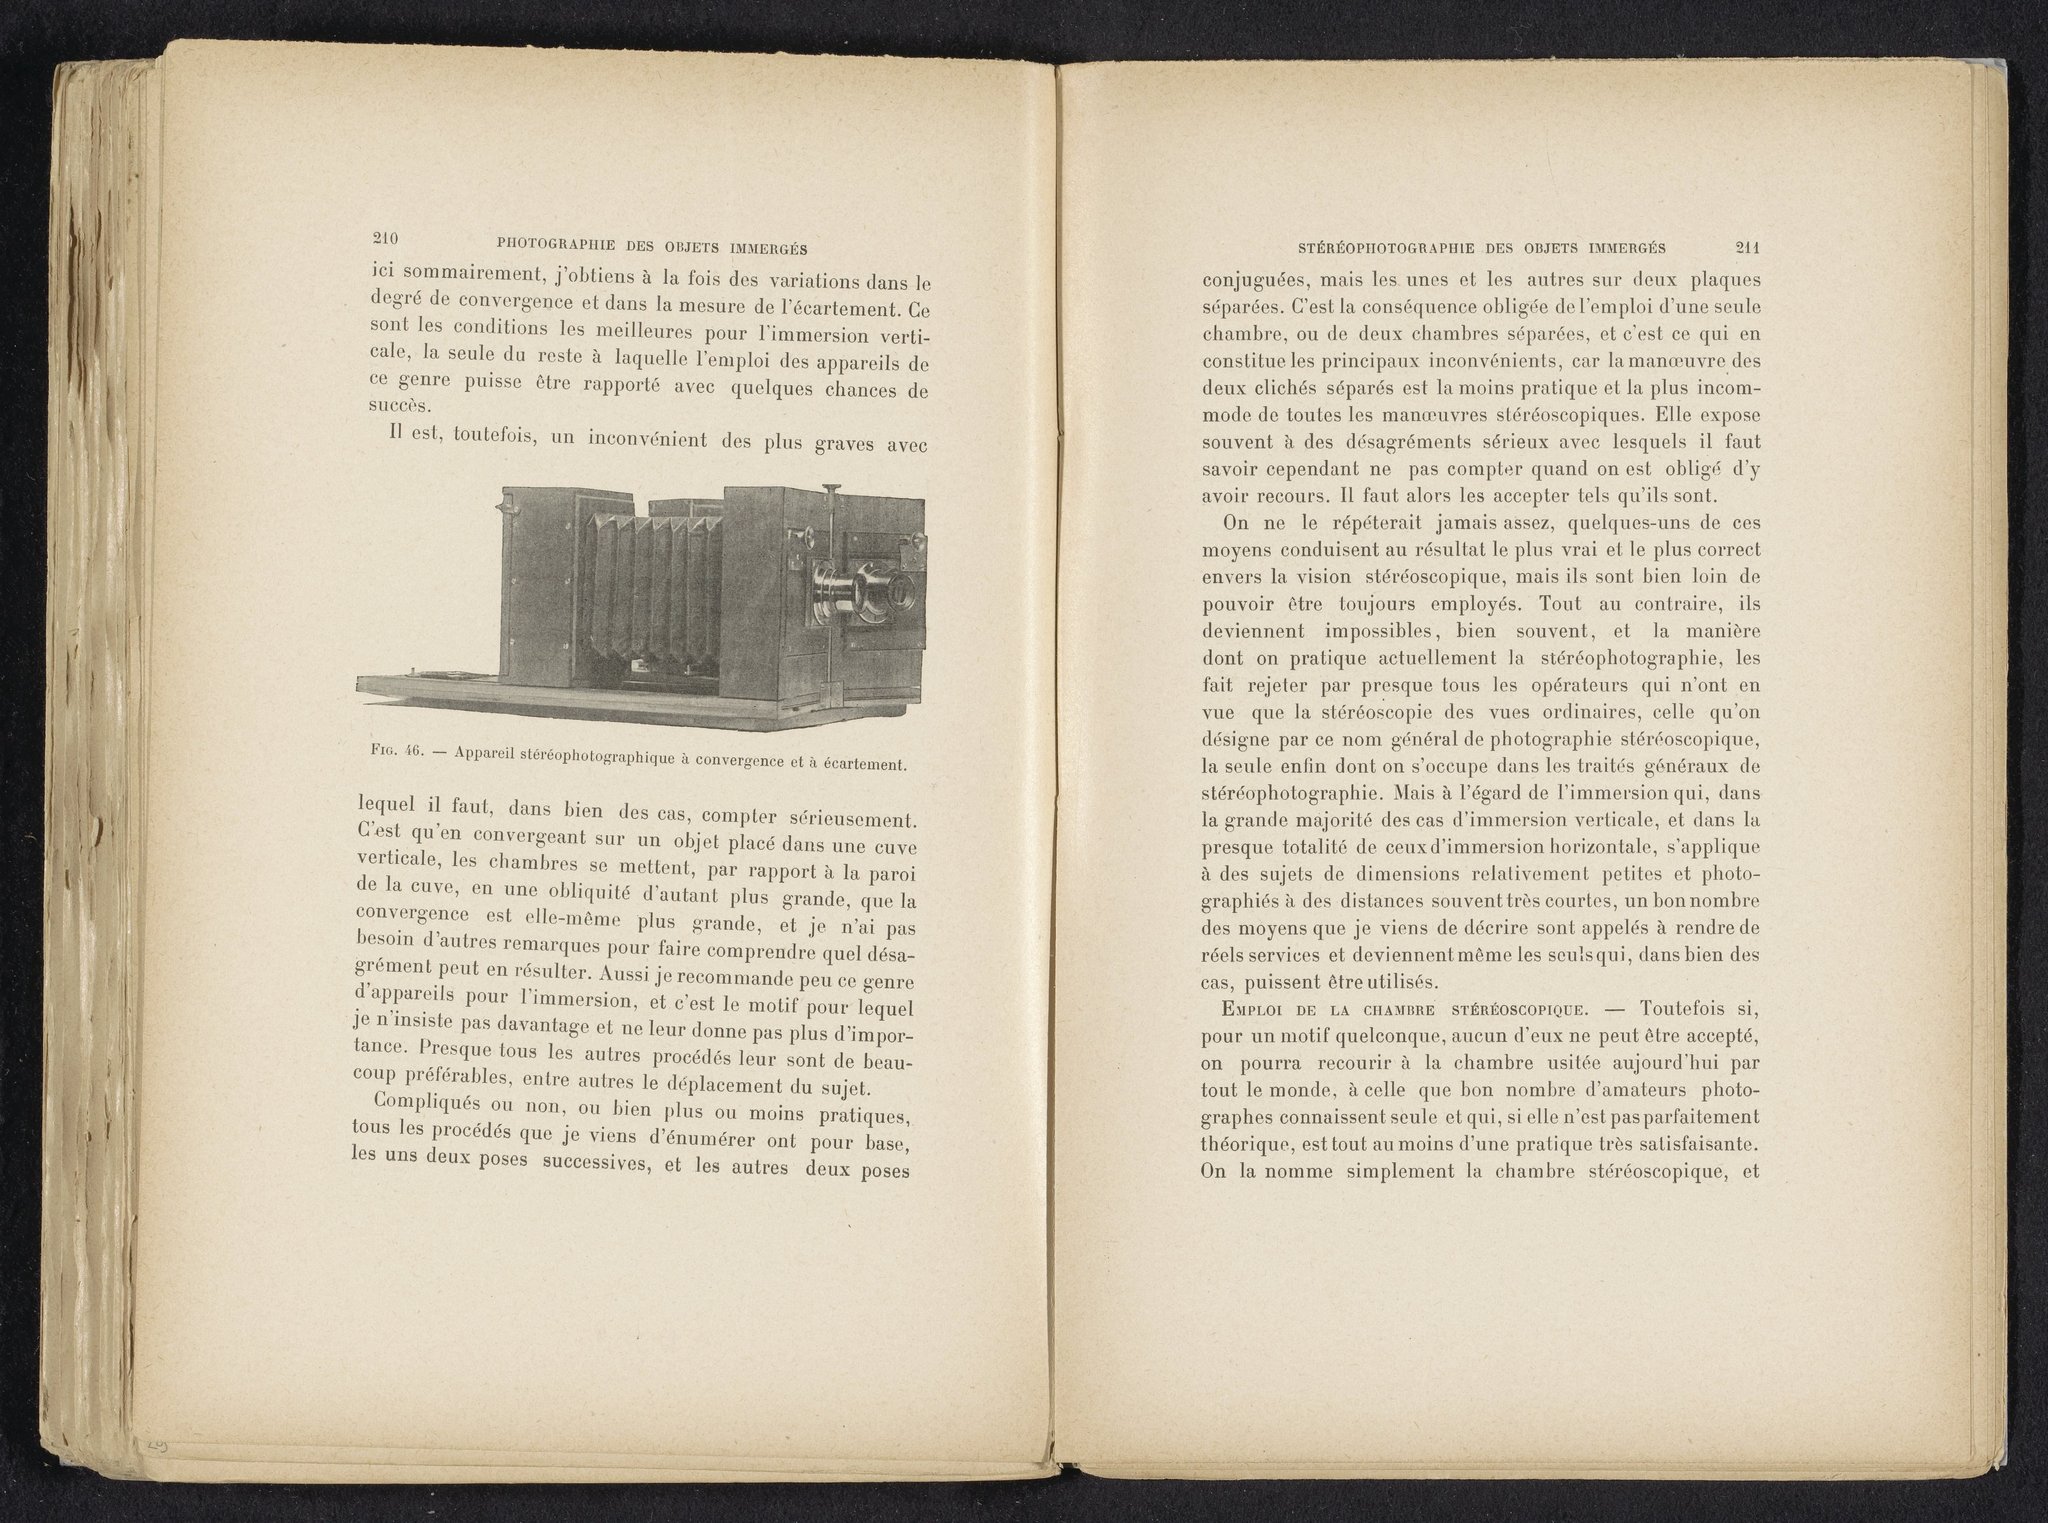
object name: page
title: Appareil stéréophotographique à convergence et à éscartement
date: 1891-1901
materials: paper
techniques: autotype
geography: paris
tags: photographic apparatus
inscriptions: number: ‘Fig. 46.’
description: Prent in album 'La photographie des objets immergés', 1901.